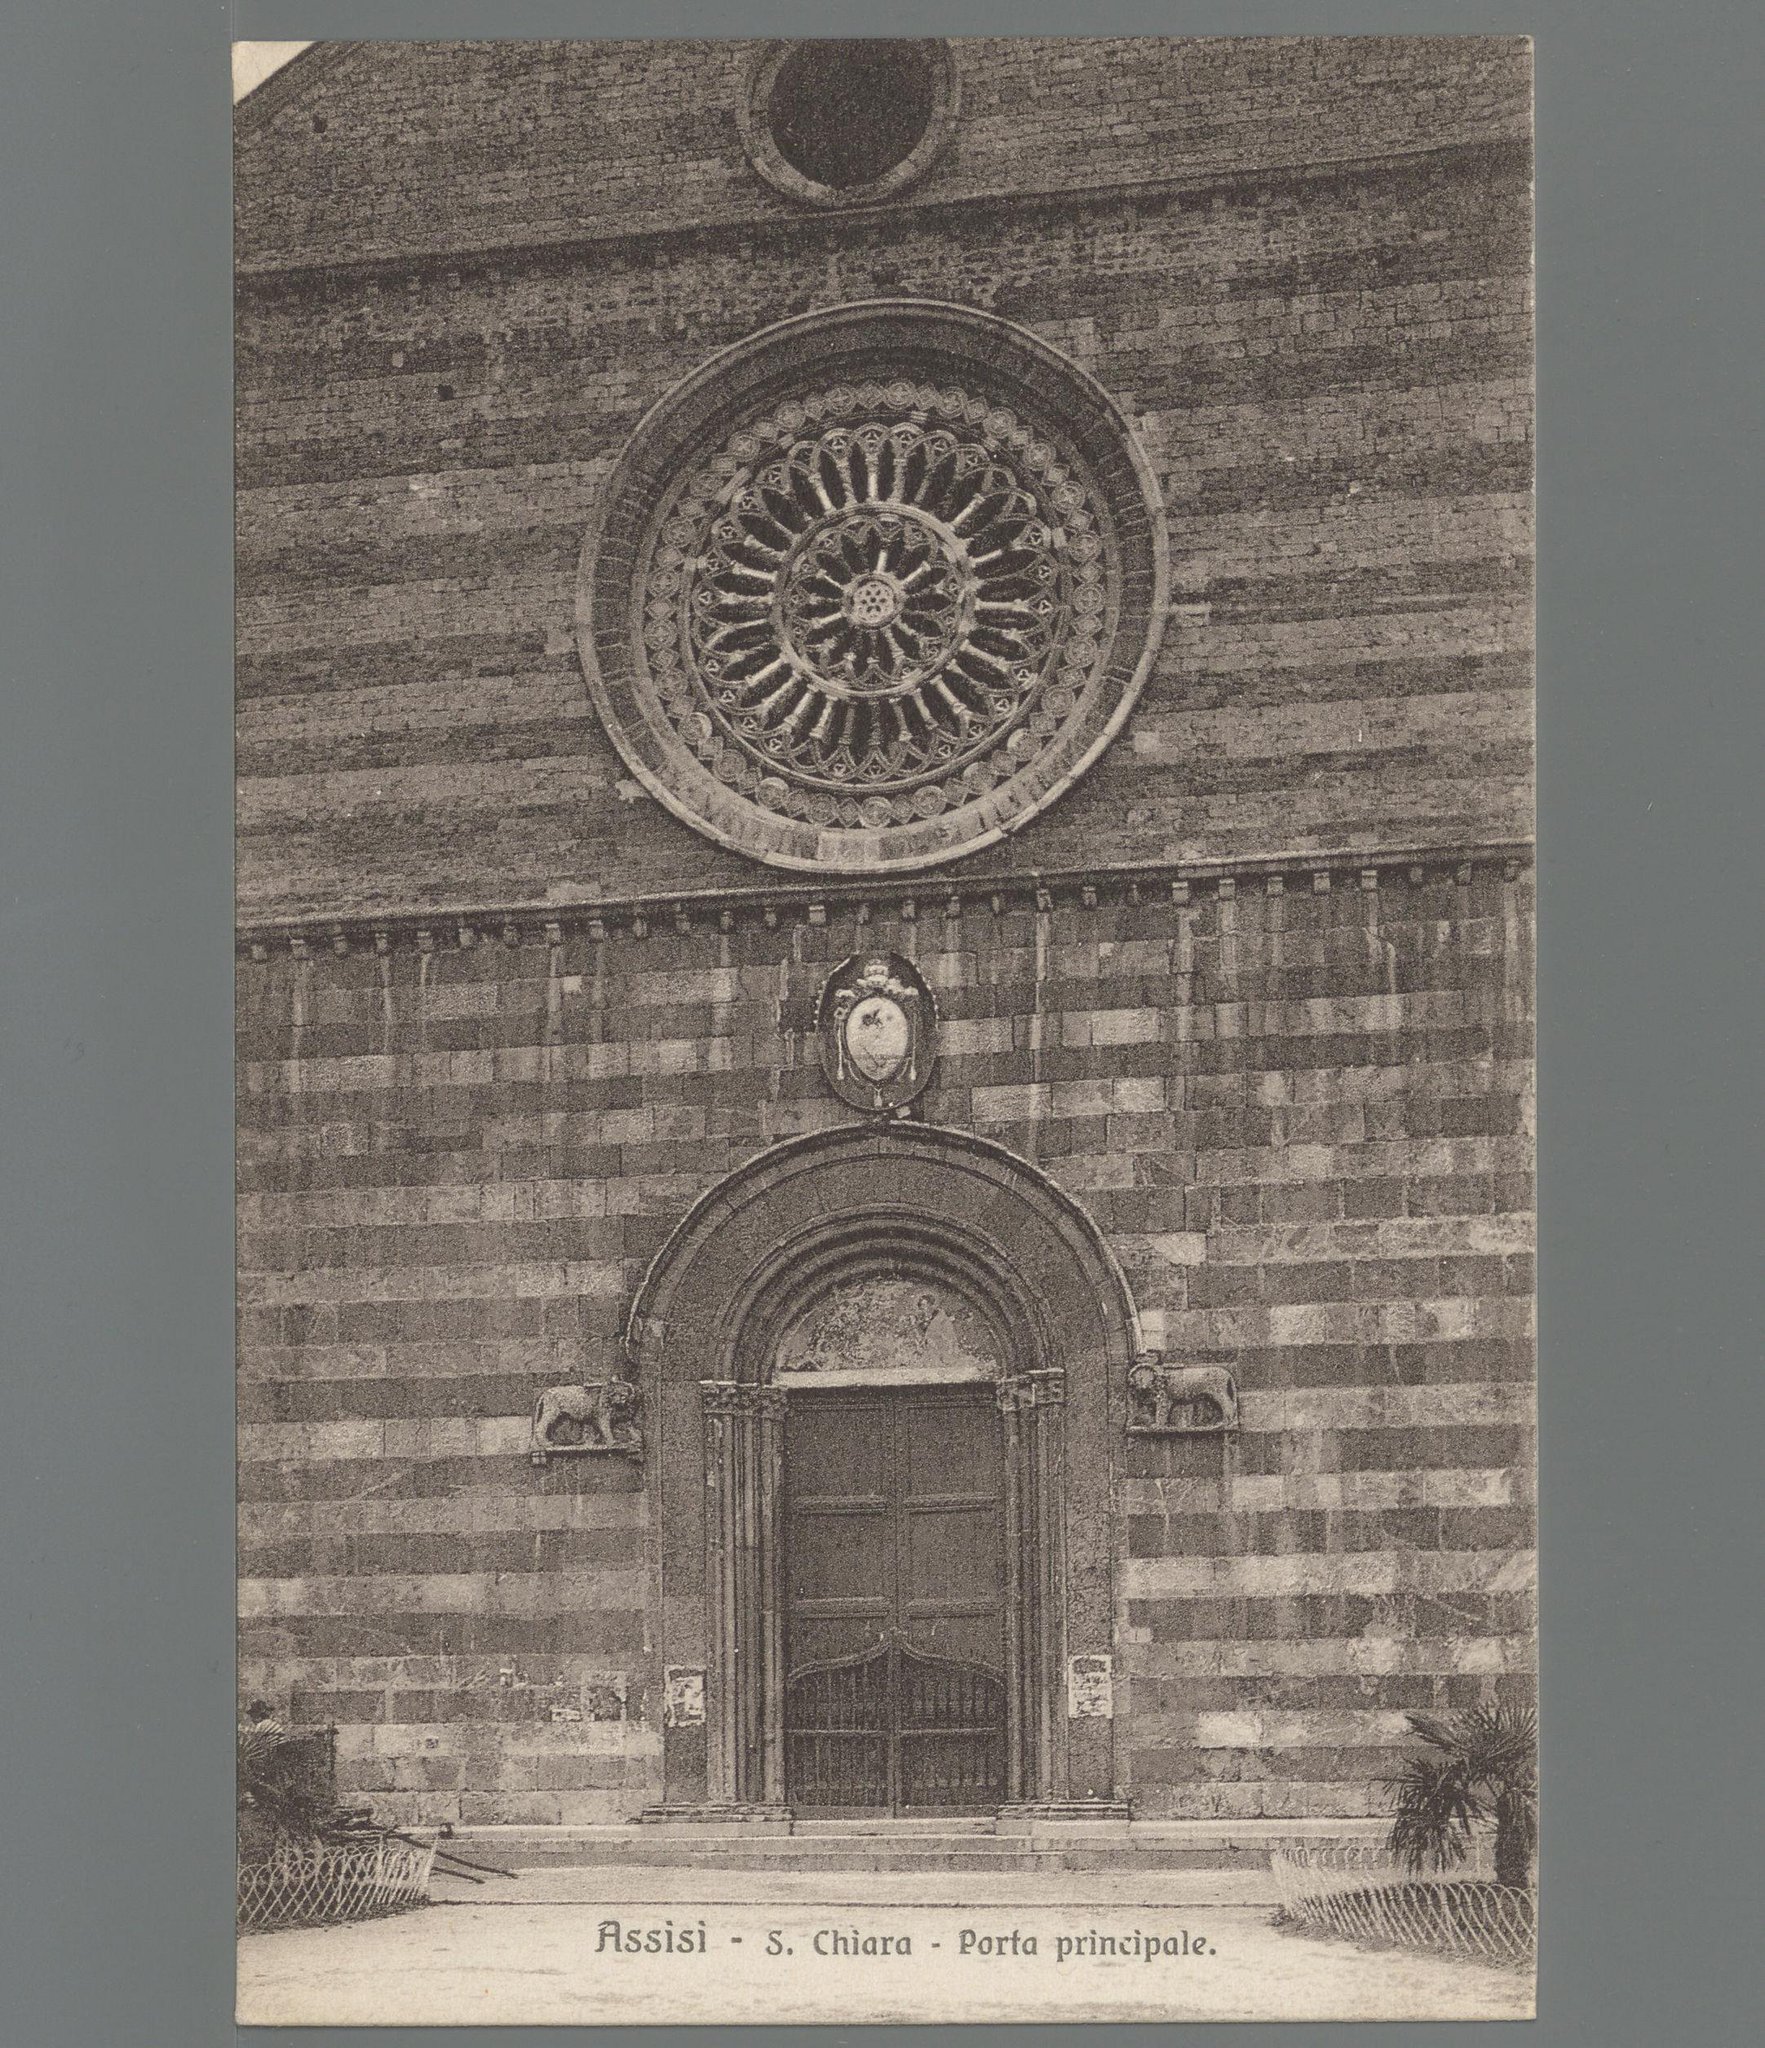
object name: photomechanical print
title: Assisi. S. Chiara. Porta principale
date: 1906-1930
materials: cardboard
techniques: photograph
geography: zurich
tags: parts of church exterior and annexes: portal